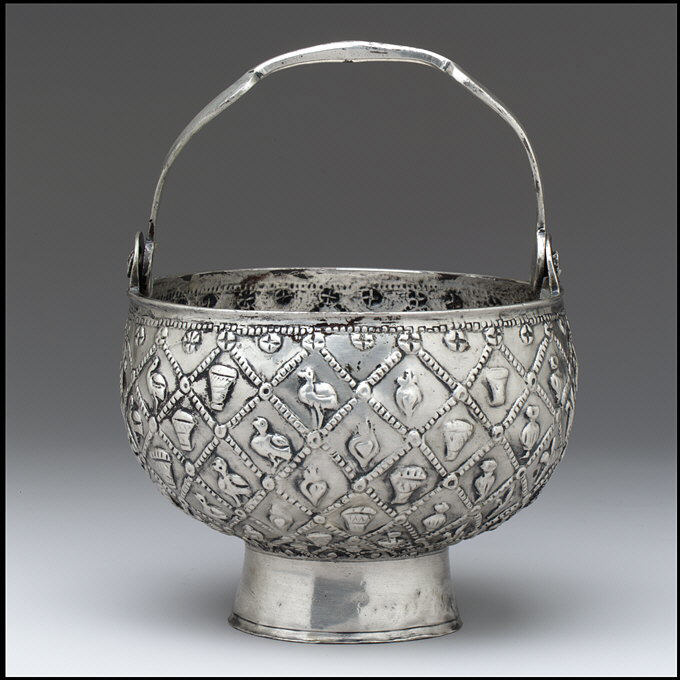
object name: bucket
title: Silver Bucket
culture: byzantine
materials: silver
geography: albania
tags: birds